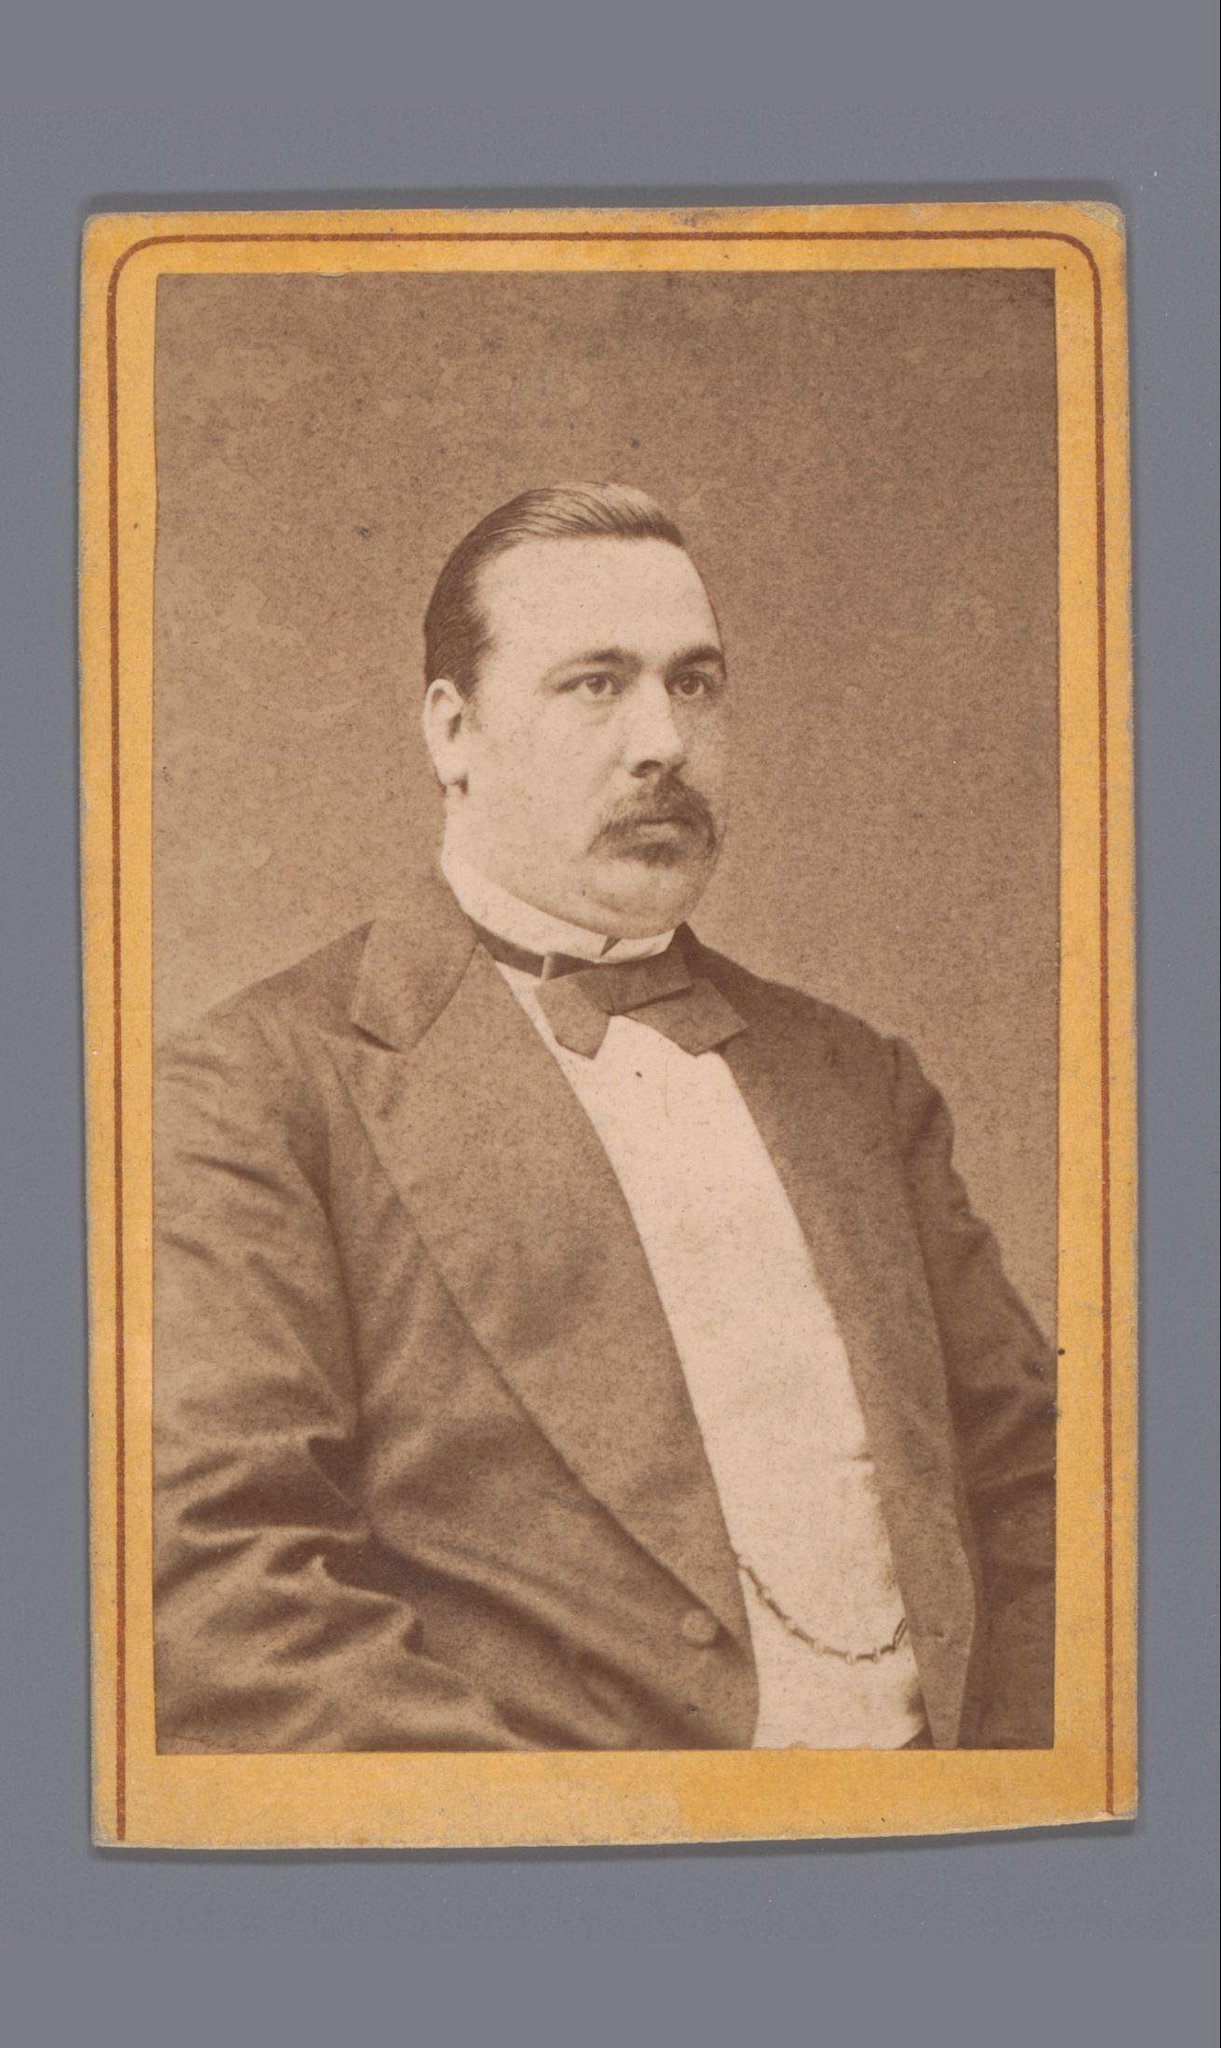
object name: photograph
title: Portret van een onbekende man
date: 1867-1880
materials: cardboard, paper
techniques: albumen print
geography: stockholm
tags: historical persons - bb - woman, adult man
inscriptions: inscription: ‘Originalplåten bevaras för vidare/ beställning.’, inscription: ‘1867/ (...)’, address: ‘HOF-PHOTOGRAFER/ STOCKHOLM/ Regeringsgatan No. 18.’